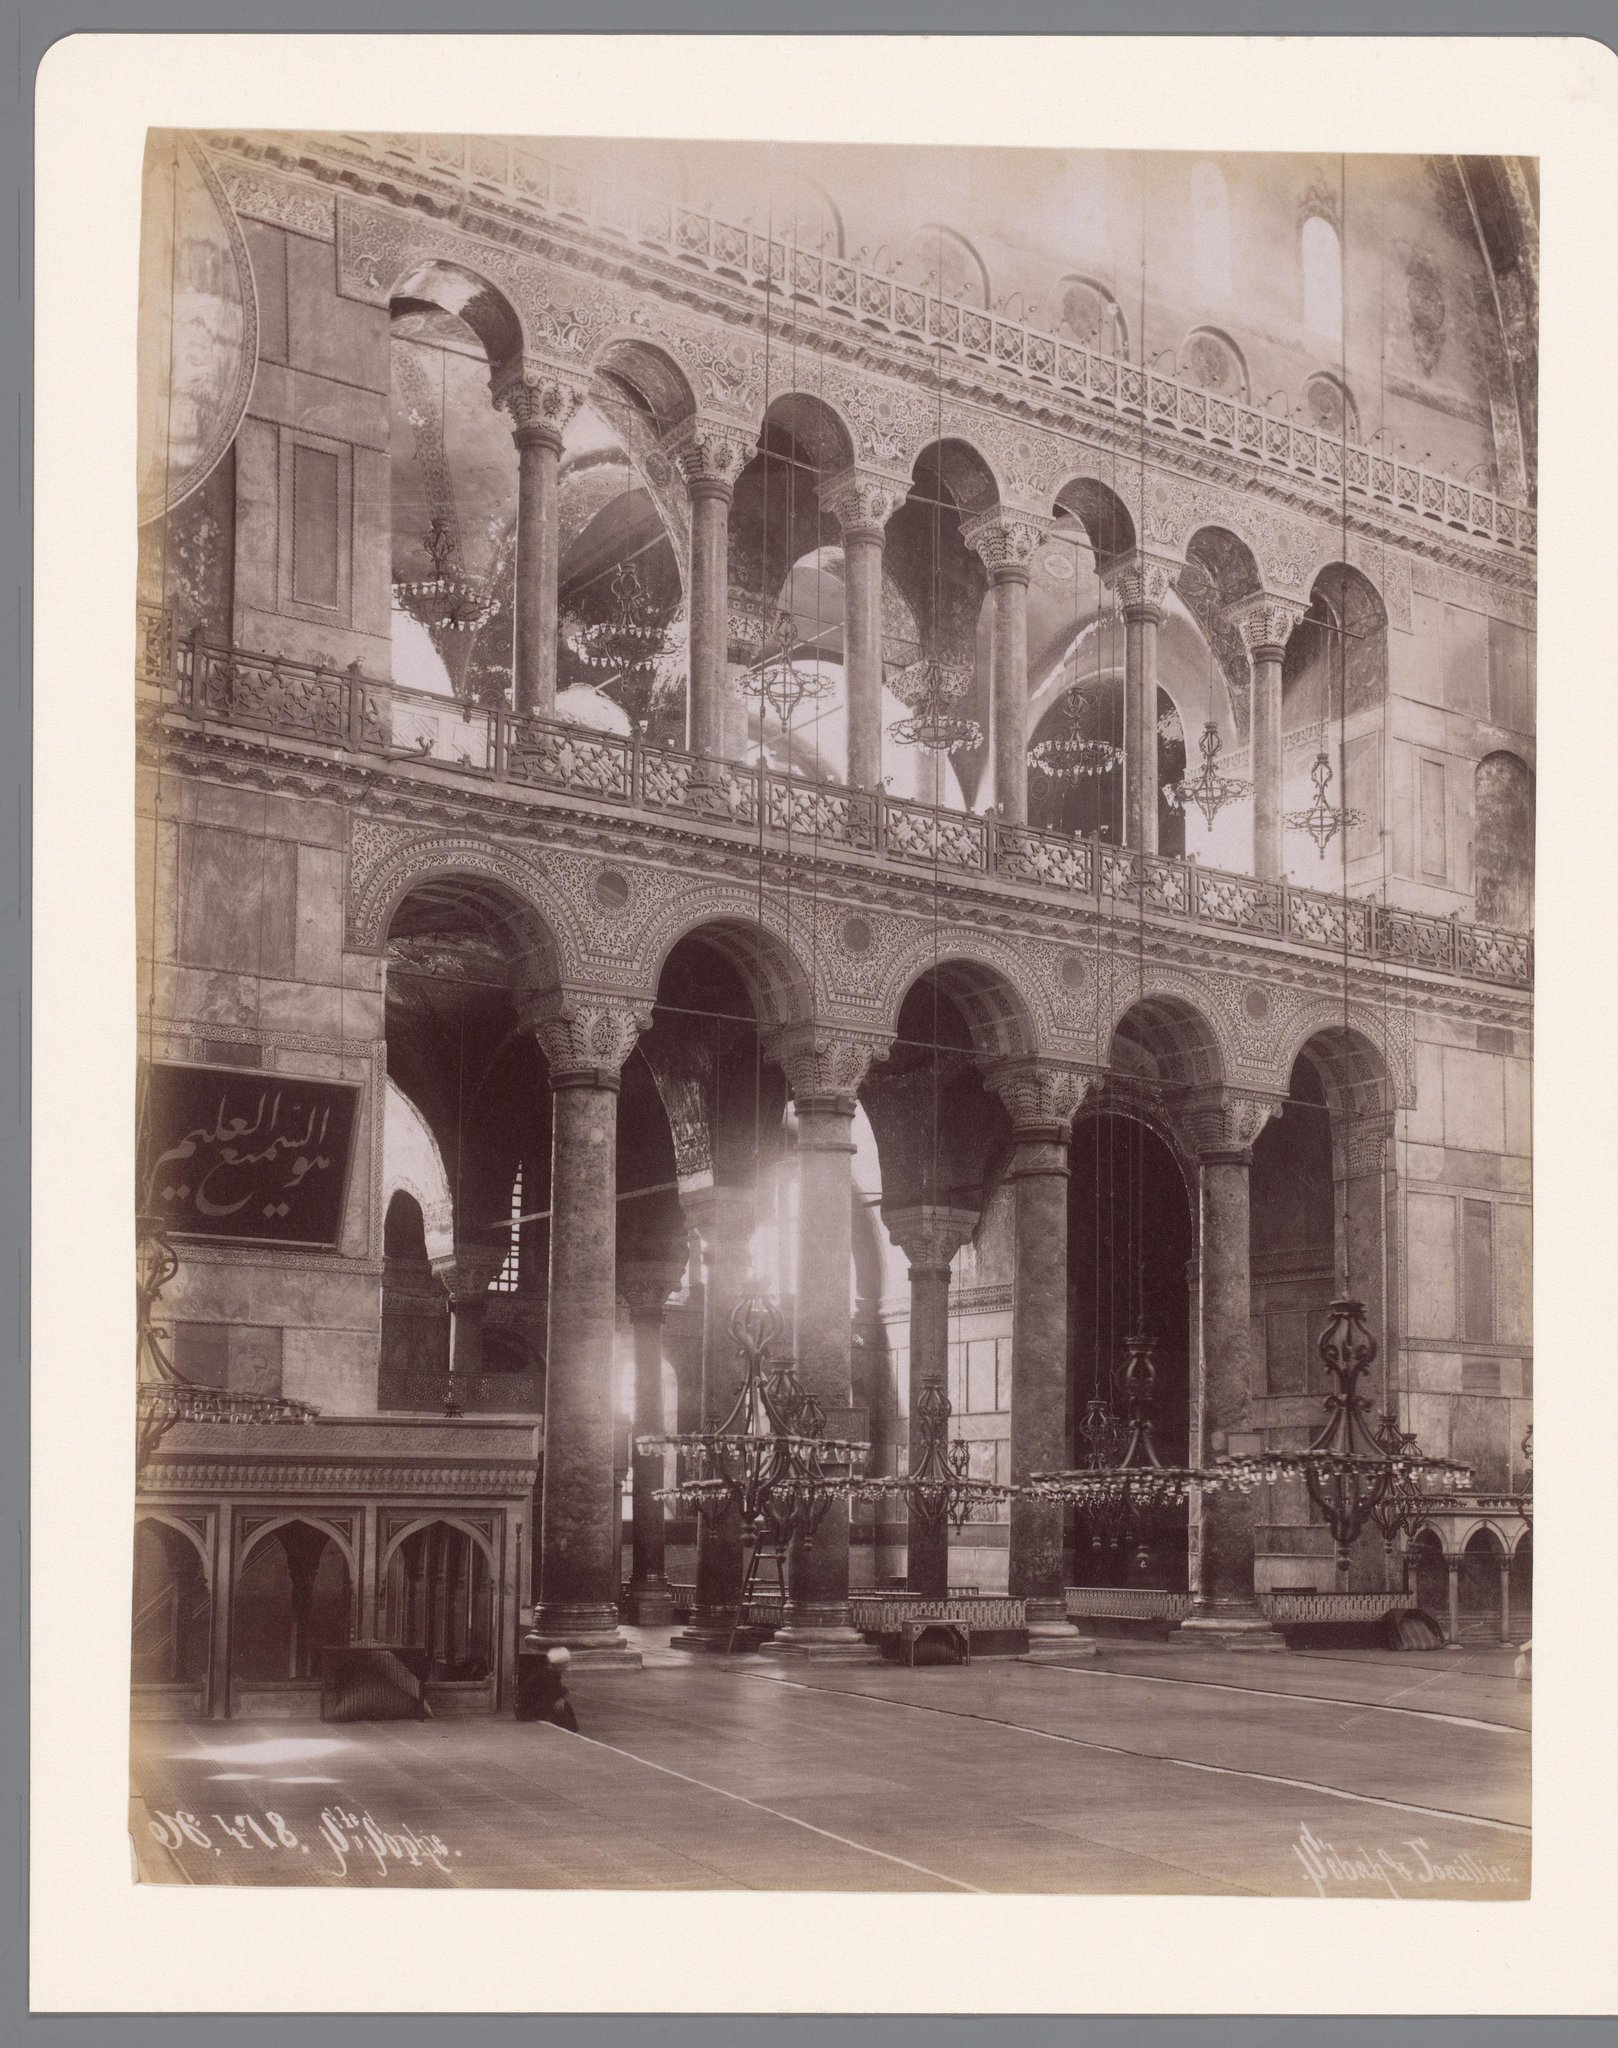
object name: photograph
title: Interieur van de Hagia Sophia in Istanboel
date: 1888-1900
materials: paper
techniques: albumen print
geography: istanbul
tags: temple, shrine ~ islam, mohammedanism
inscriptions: number: ‘N. 478.’